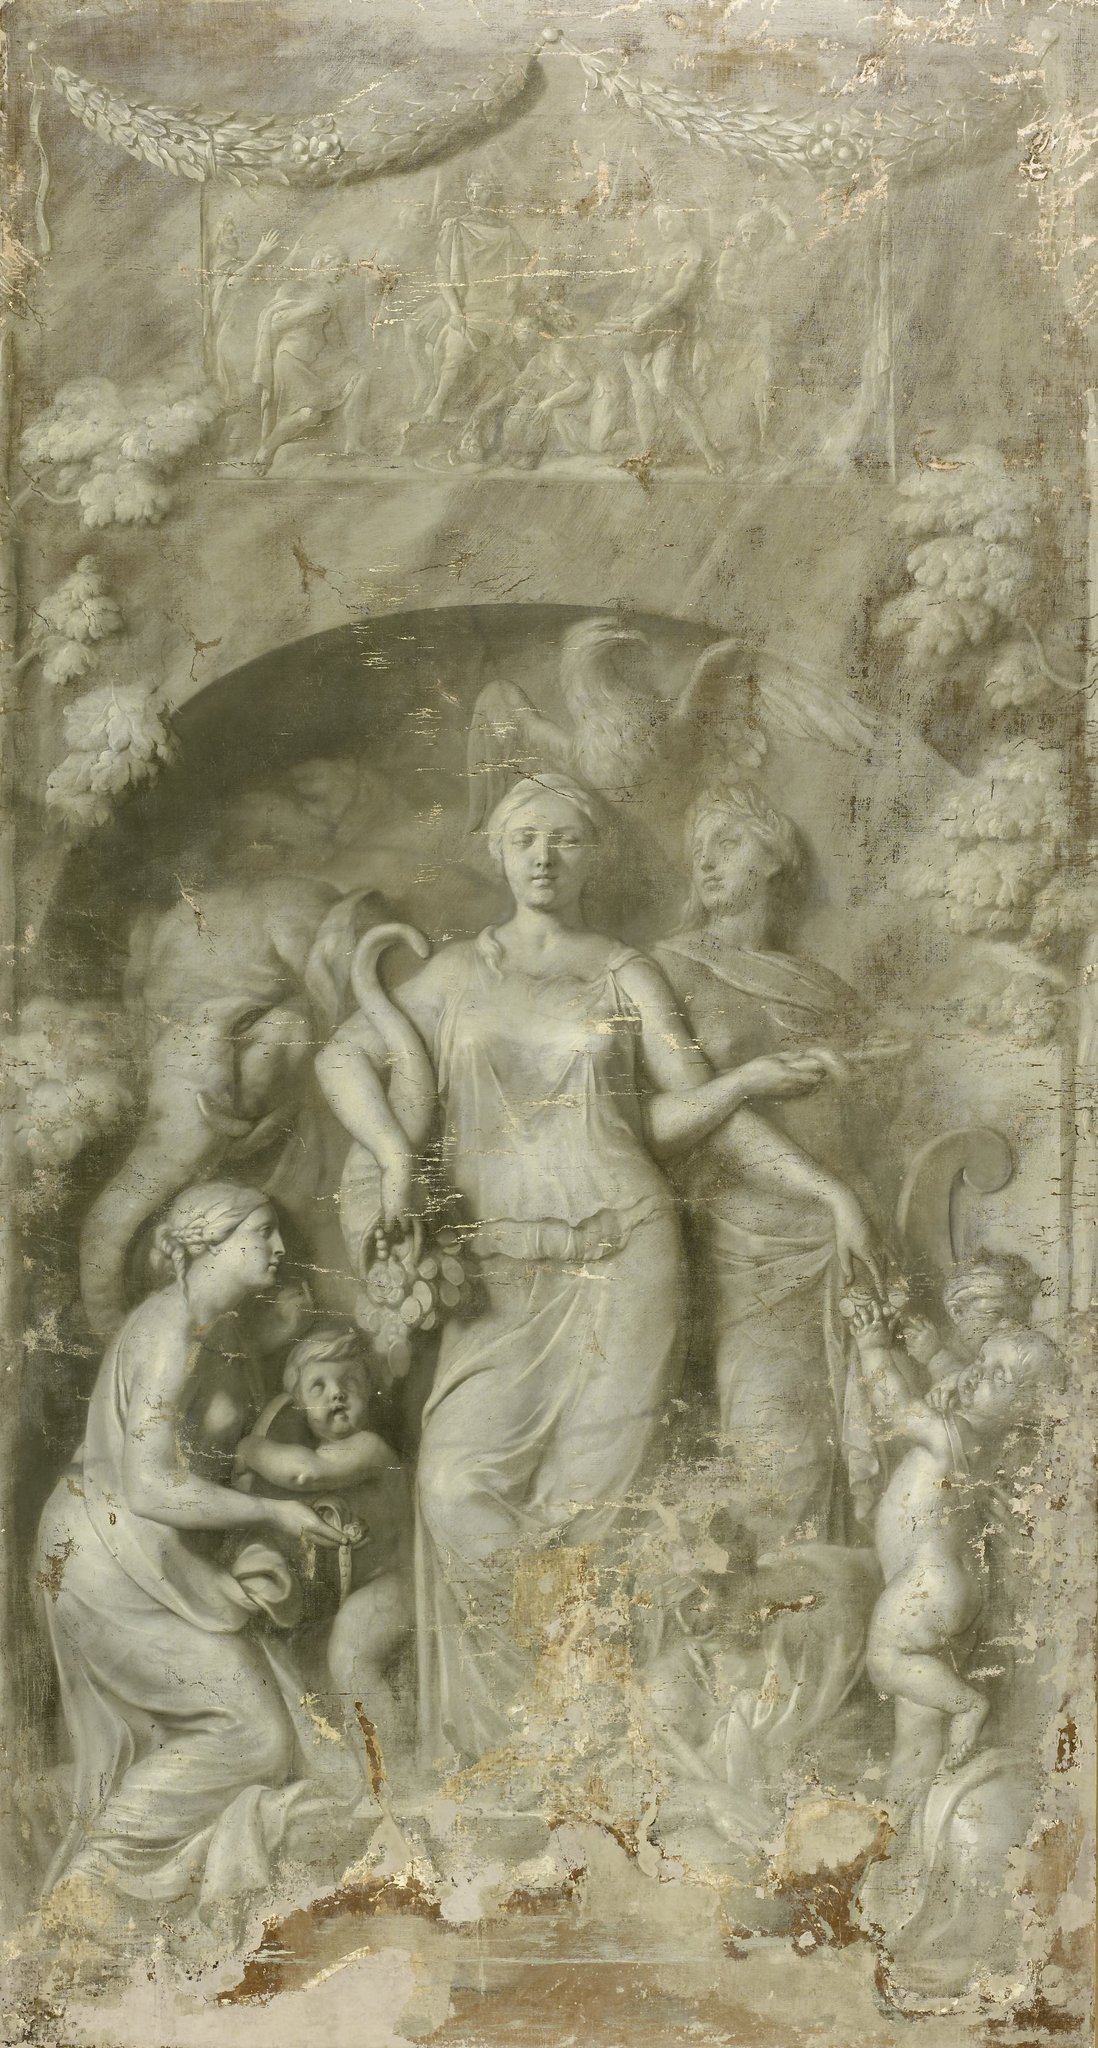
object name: painting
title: Allegory of Charity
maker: gerard de lairesse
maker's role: draughtsman, painter, print maker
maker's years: 1641-1711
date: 1675-1683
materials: canvas, oil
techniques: grisaille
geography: northern netherlands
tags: generosity, liberality; 'generosità', 'liberalità' (ripa) (+ abstract concept represented by female figure)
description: Hier deelt een vrouw geld uit aan de armen, rechts staat een bedelaar. Op de achtergrond staan een olifant en een adelaar afgebeeld. Liefdadigheid was een van de belangrijkste deugden die de welvarende Philips de Flines behoorde te bezitten.